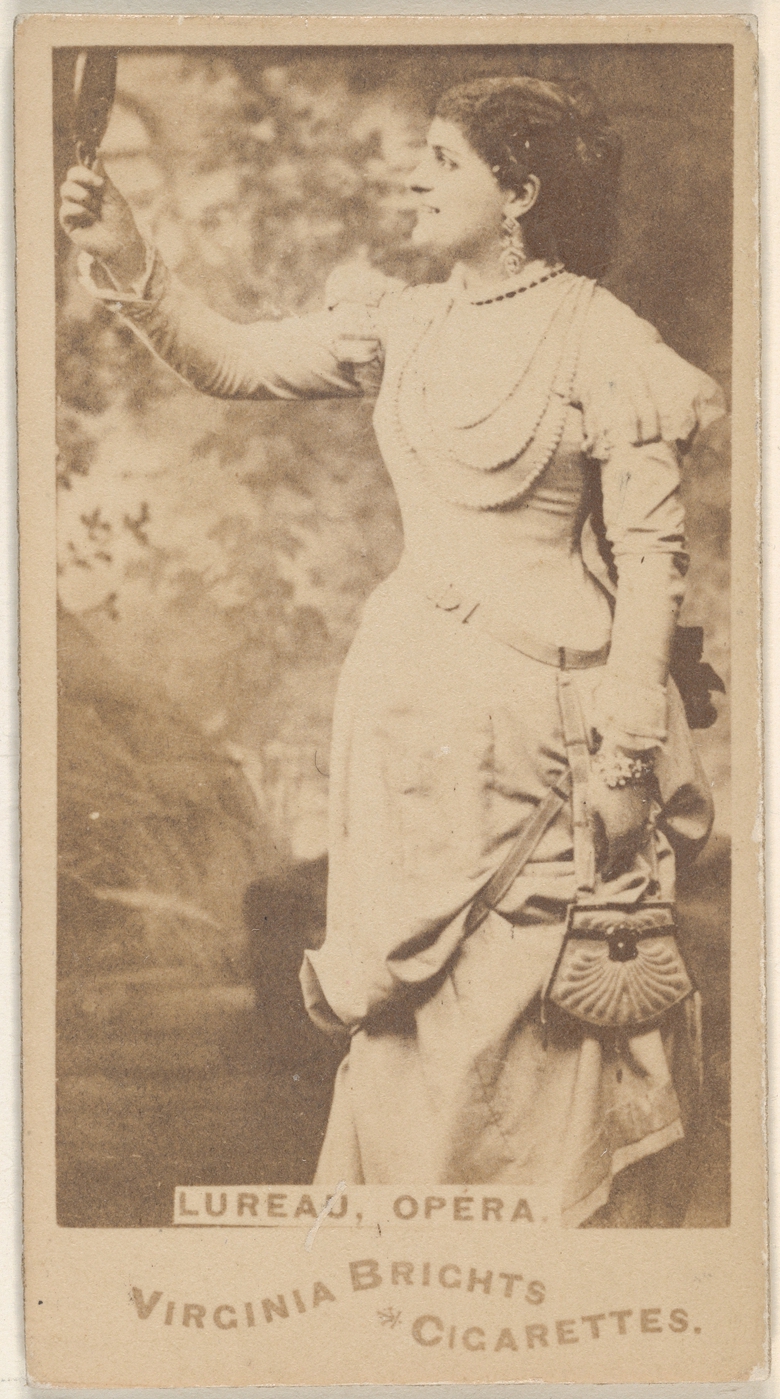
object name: photograph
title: Lureau, Opera, from the Actors and Actresses series (N45, Type 1) for Virginia Brights Cigarettes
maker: allen & ginter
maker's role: publisher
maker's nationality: american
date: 1888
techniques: albumen silver print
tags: women,actresses